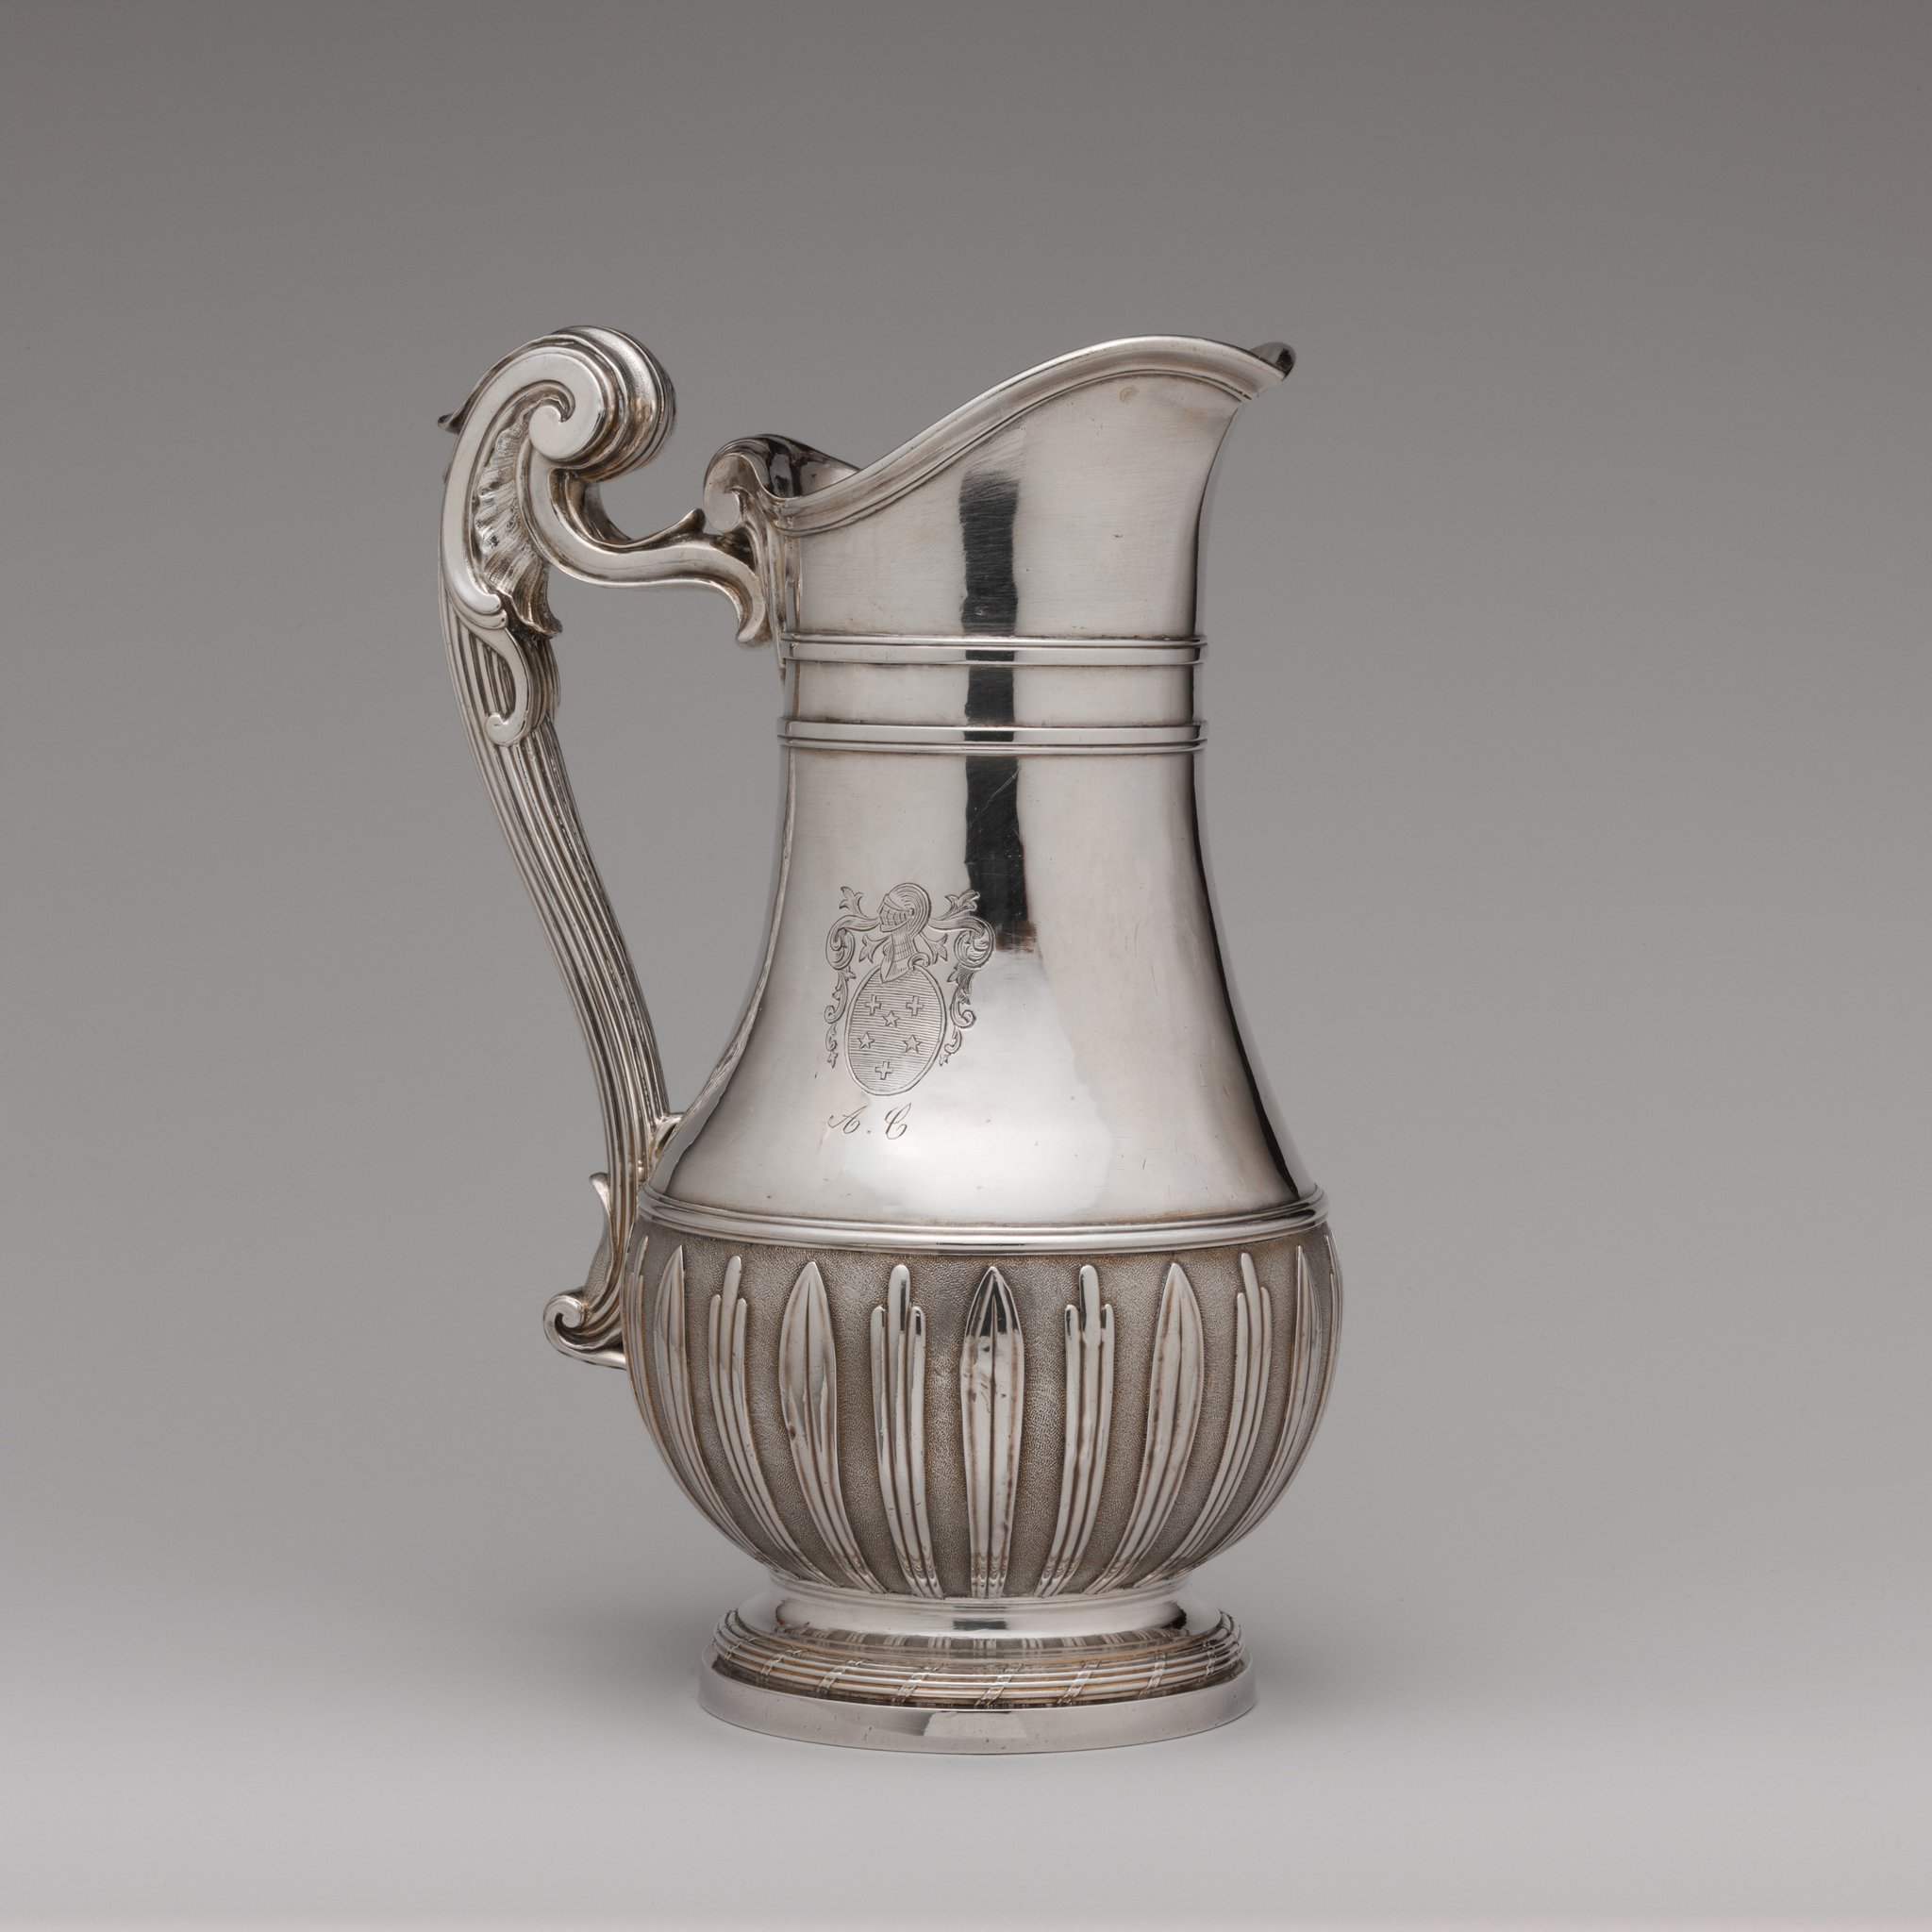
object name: ewer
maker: thomas germain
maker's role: maker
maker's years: 1674-1748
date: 1736-1737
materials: silver